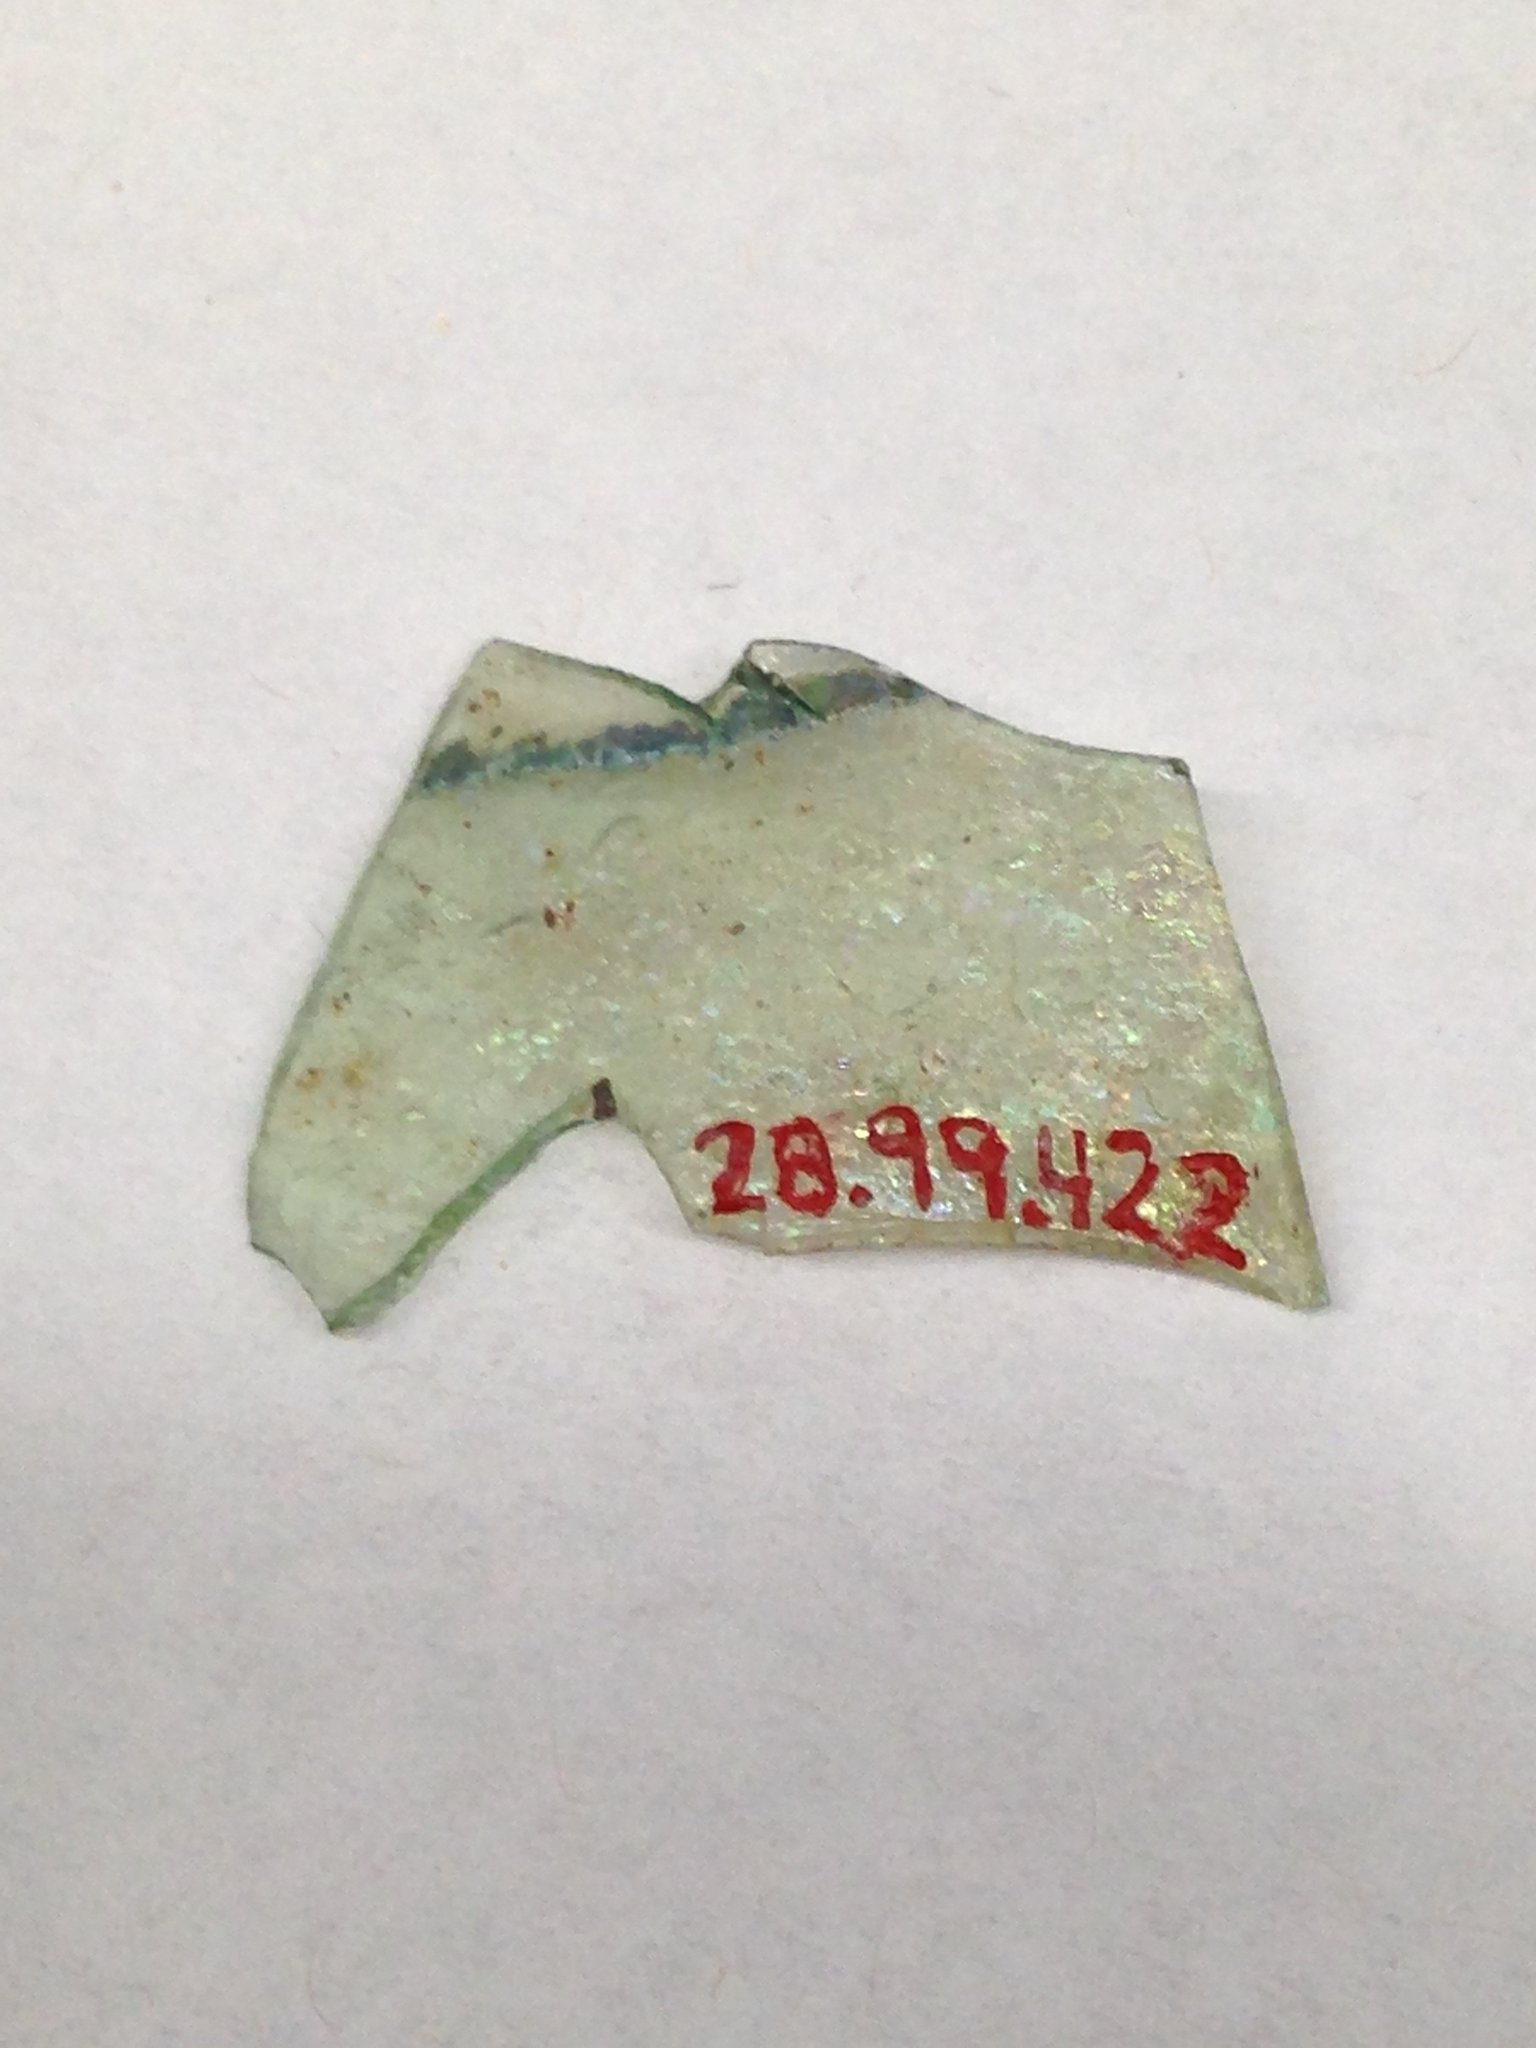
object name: fragment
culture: european or middle eastern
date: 1150-1250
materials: ceramic, glass